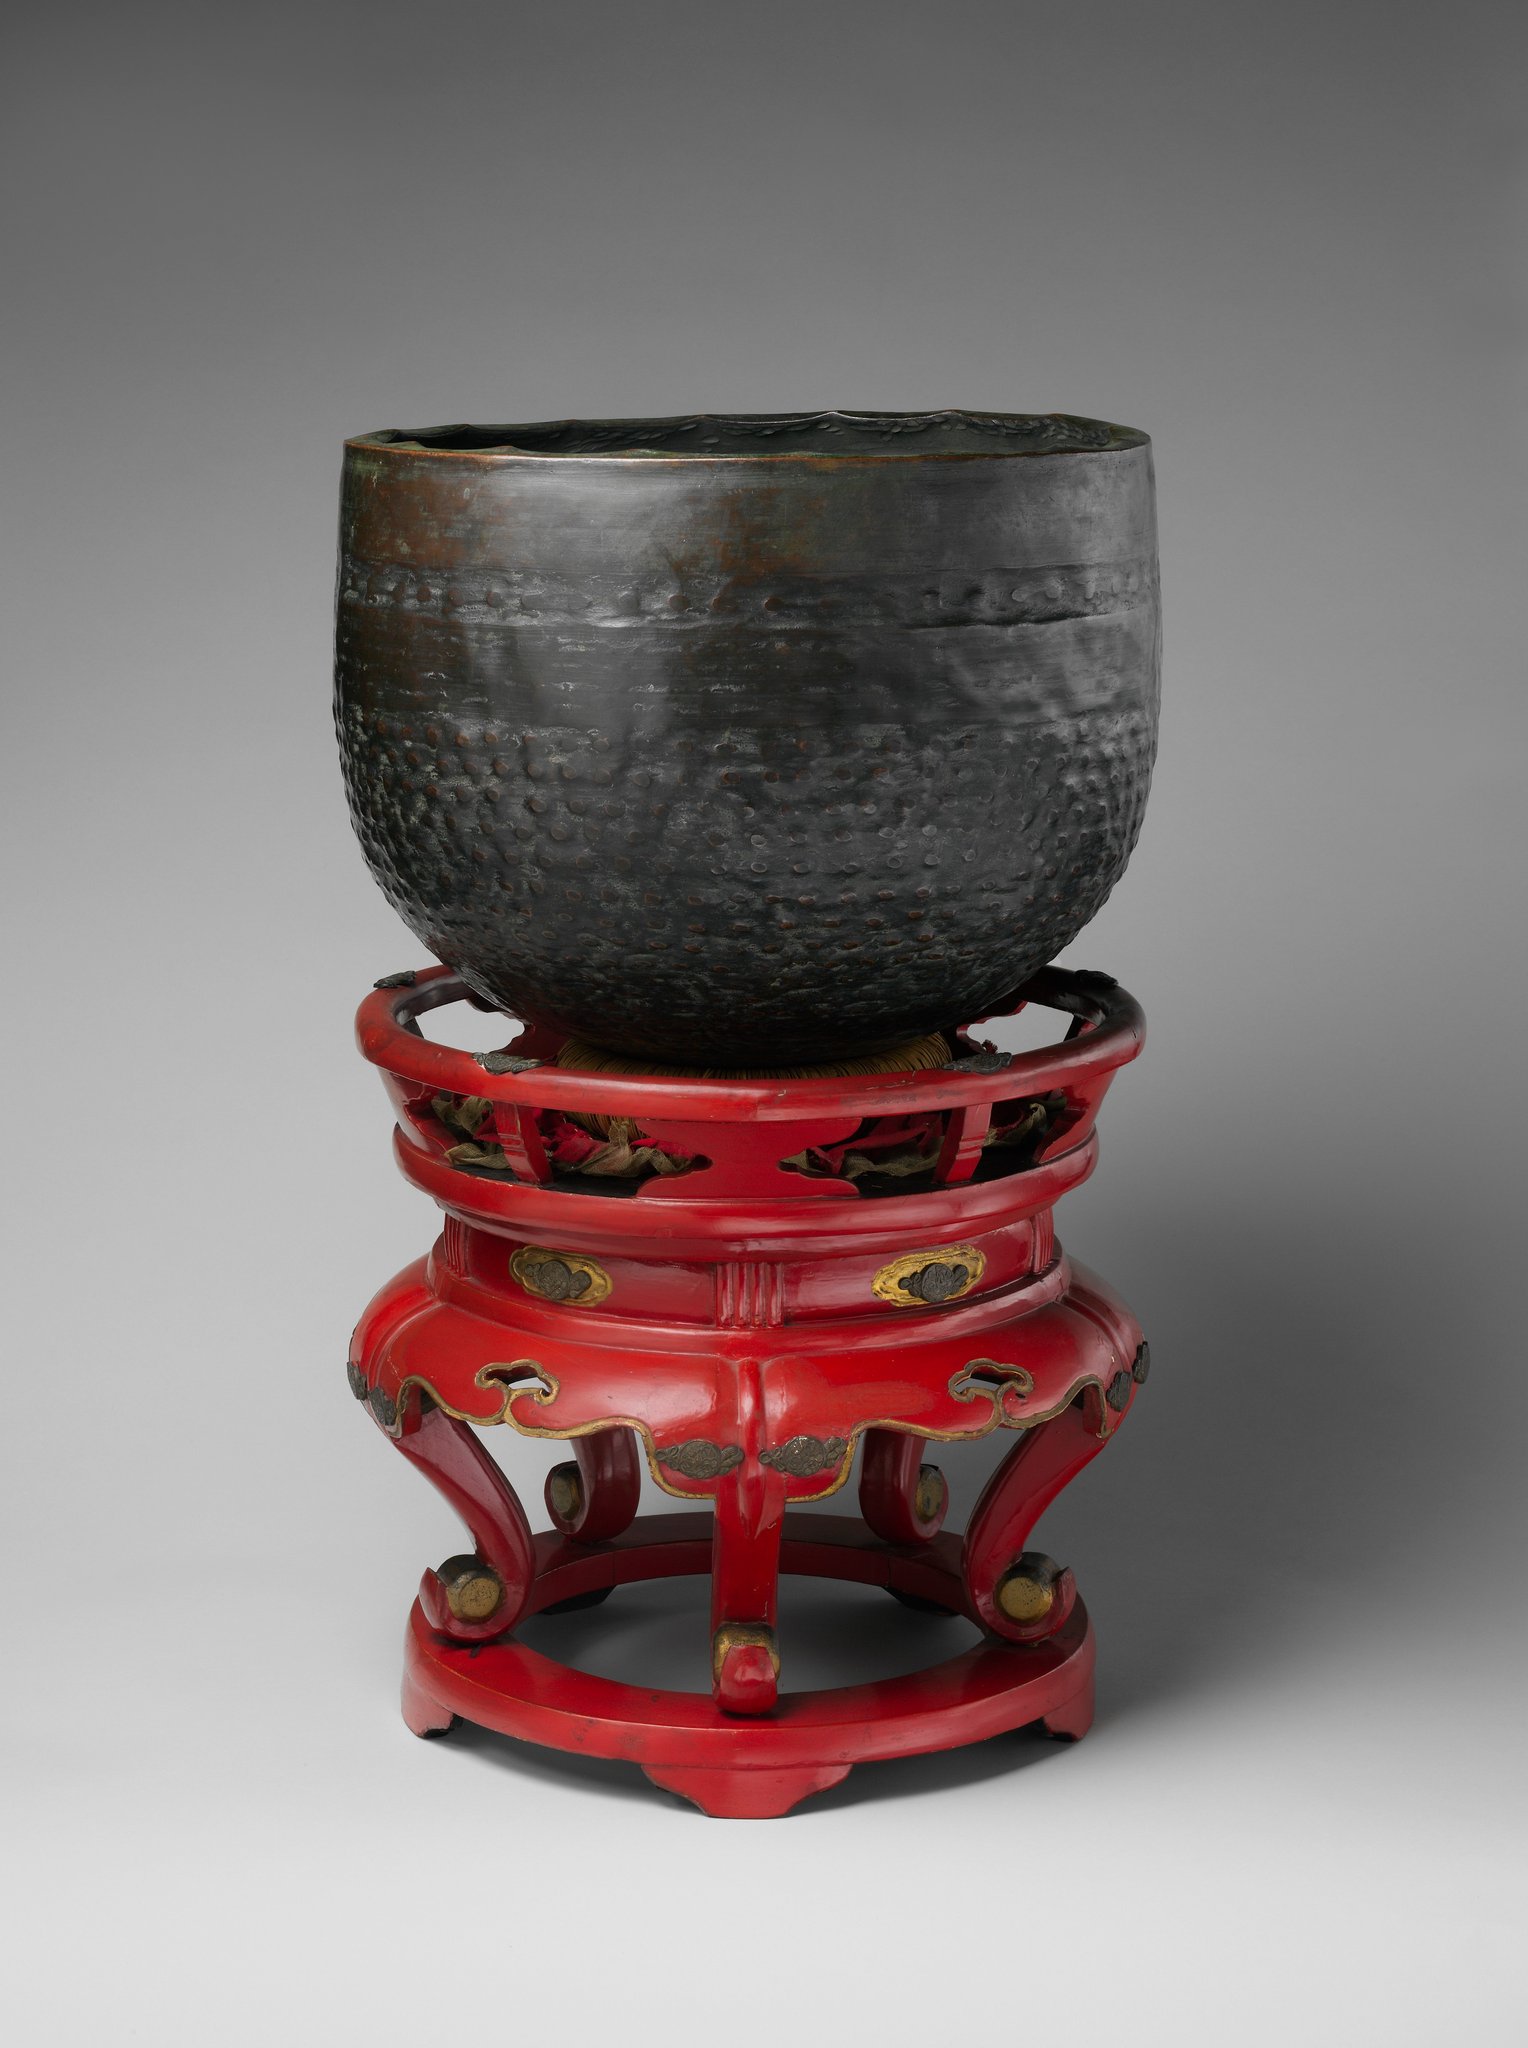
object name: dobachi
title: Dobachi (銅鉢)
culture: japanese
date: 1801-1900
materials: lacquer, metal, wood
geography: japan